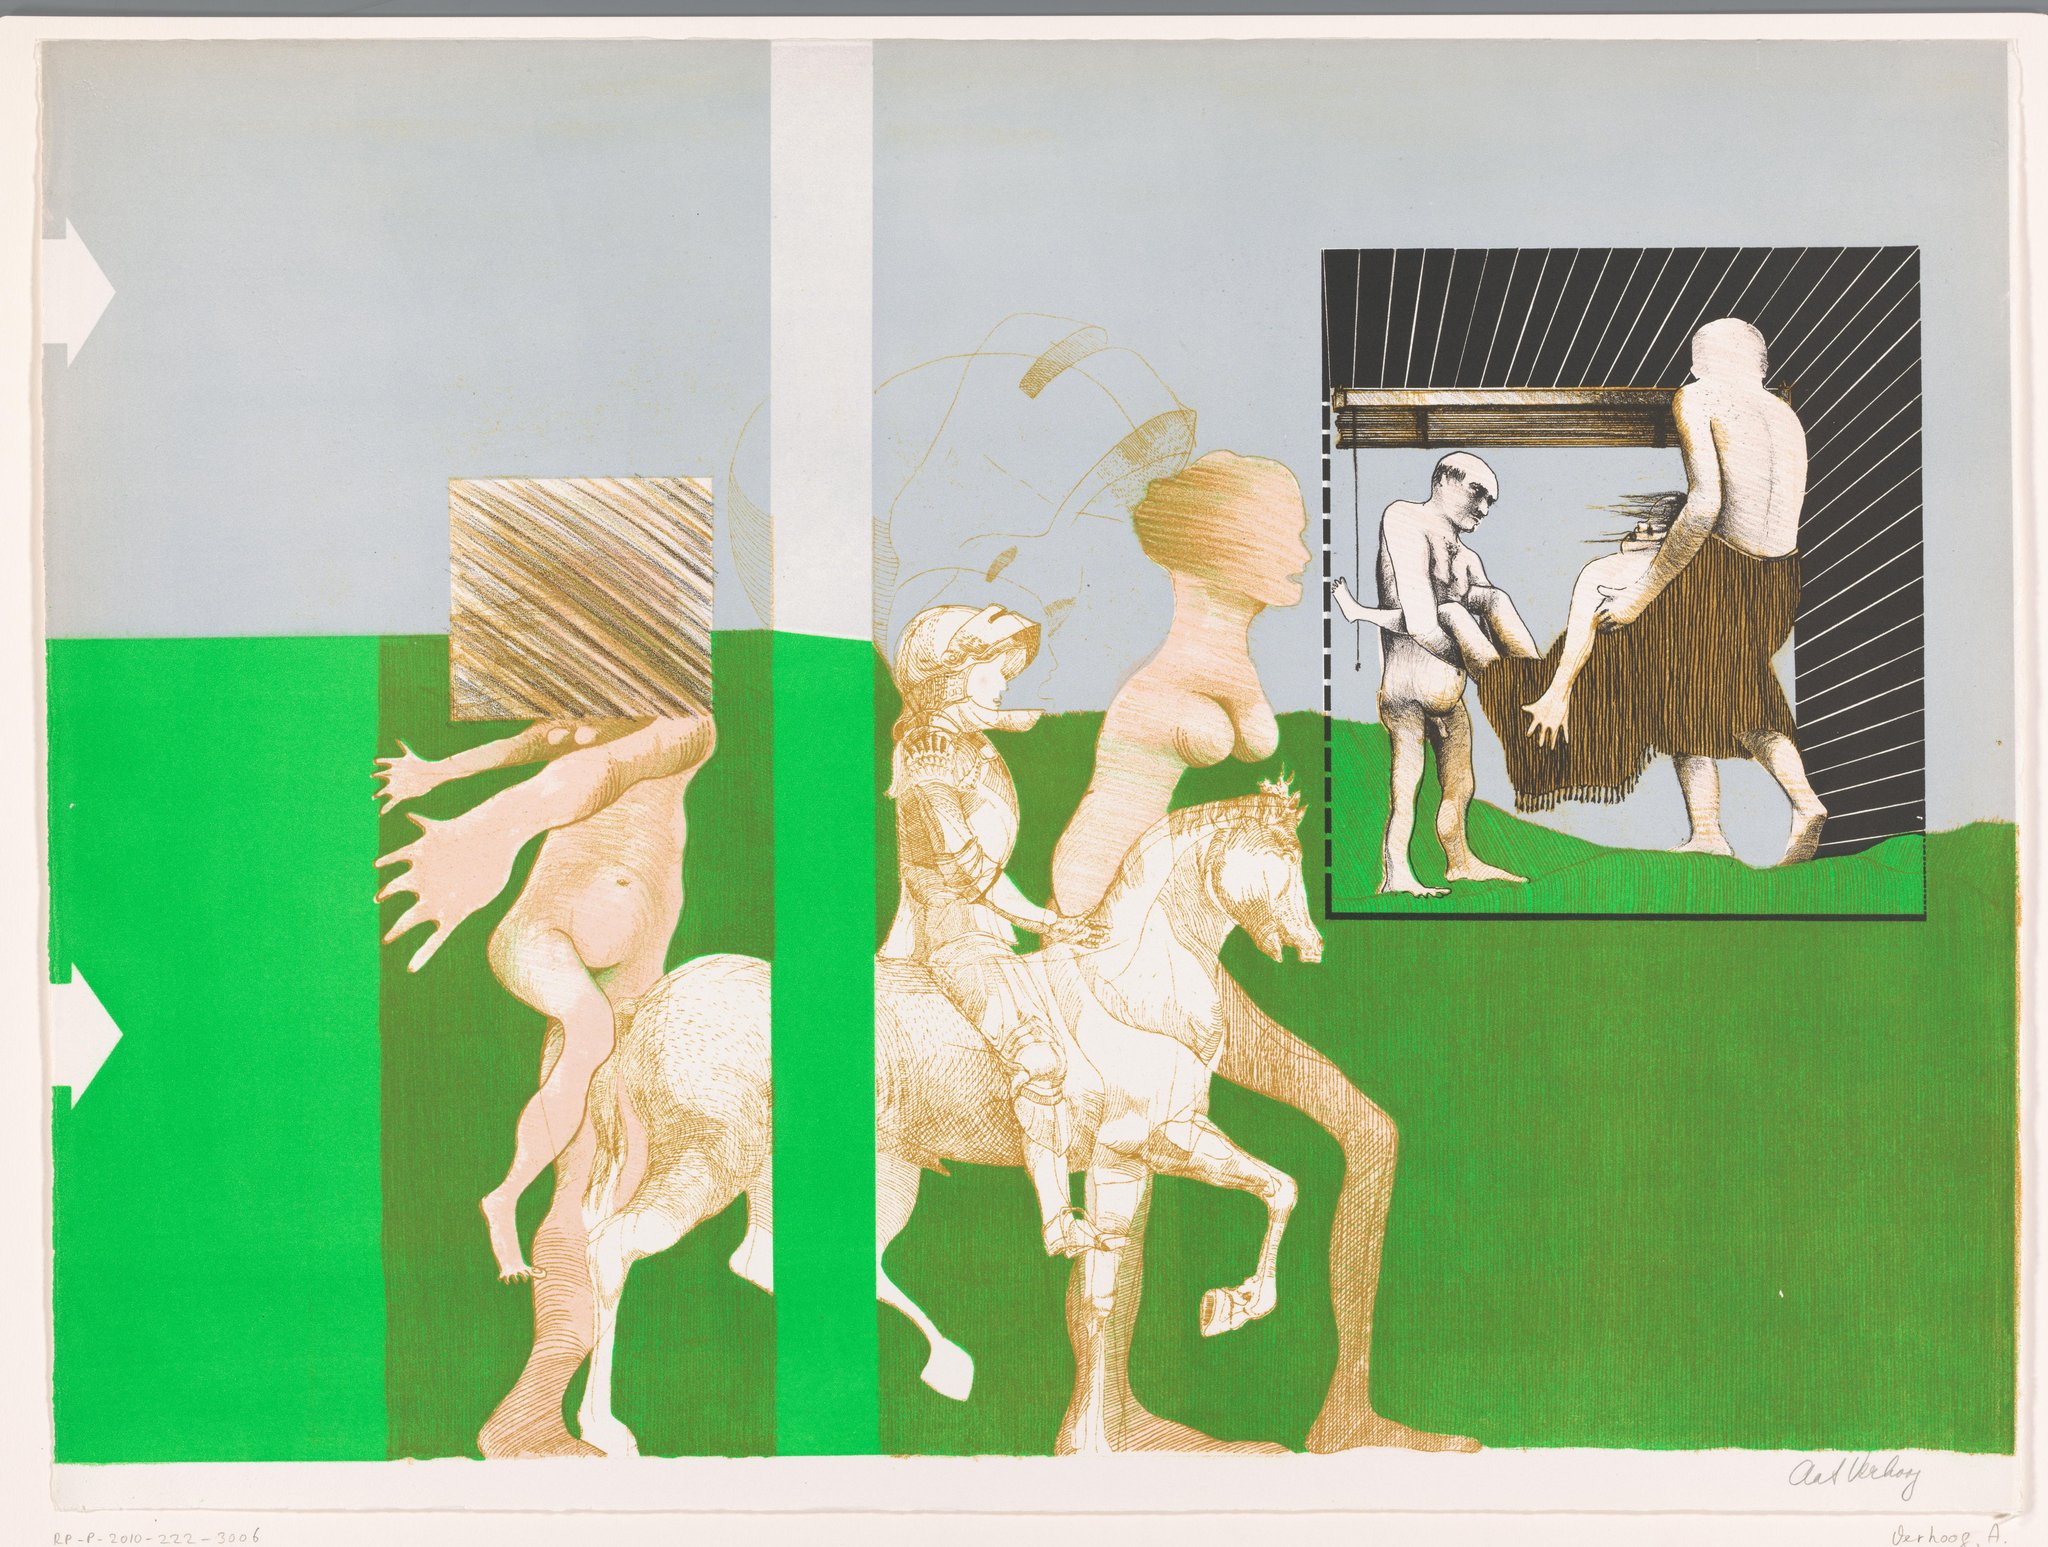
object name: print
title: Ridder te paard en naakten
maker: aat verhoog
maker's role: print maker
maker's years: 1933-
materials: paper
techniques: lithograph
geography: netherlands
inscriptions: signature: ‘Aat Verhoog’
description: Ridder te paard met achter hem een armloos naakt, rechtsboven twee mannen die een derde bij de knie- en armholtes vasthouden. Een felgroene achtergrond onder de horizon.